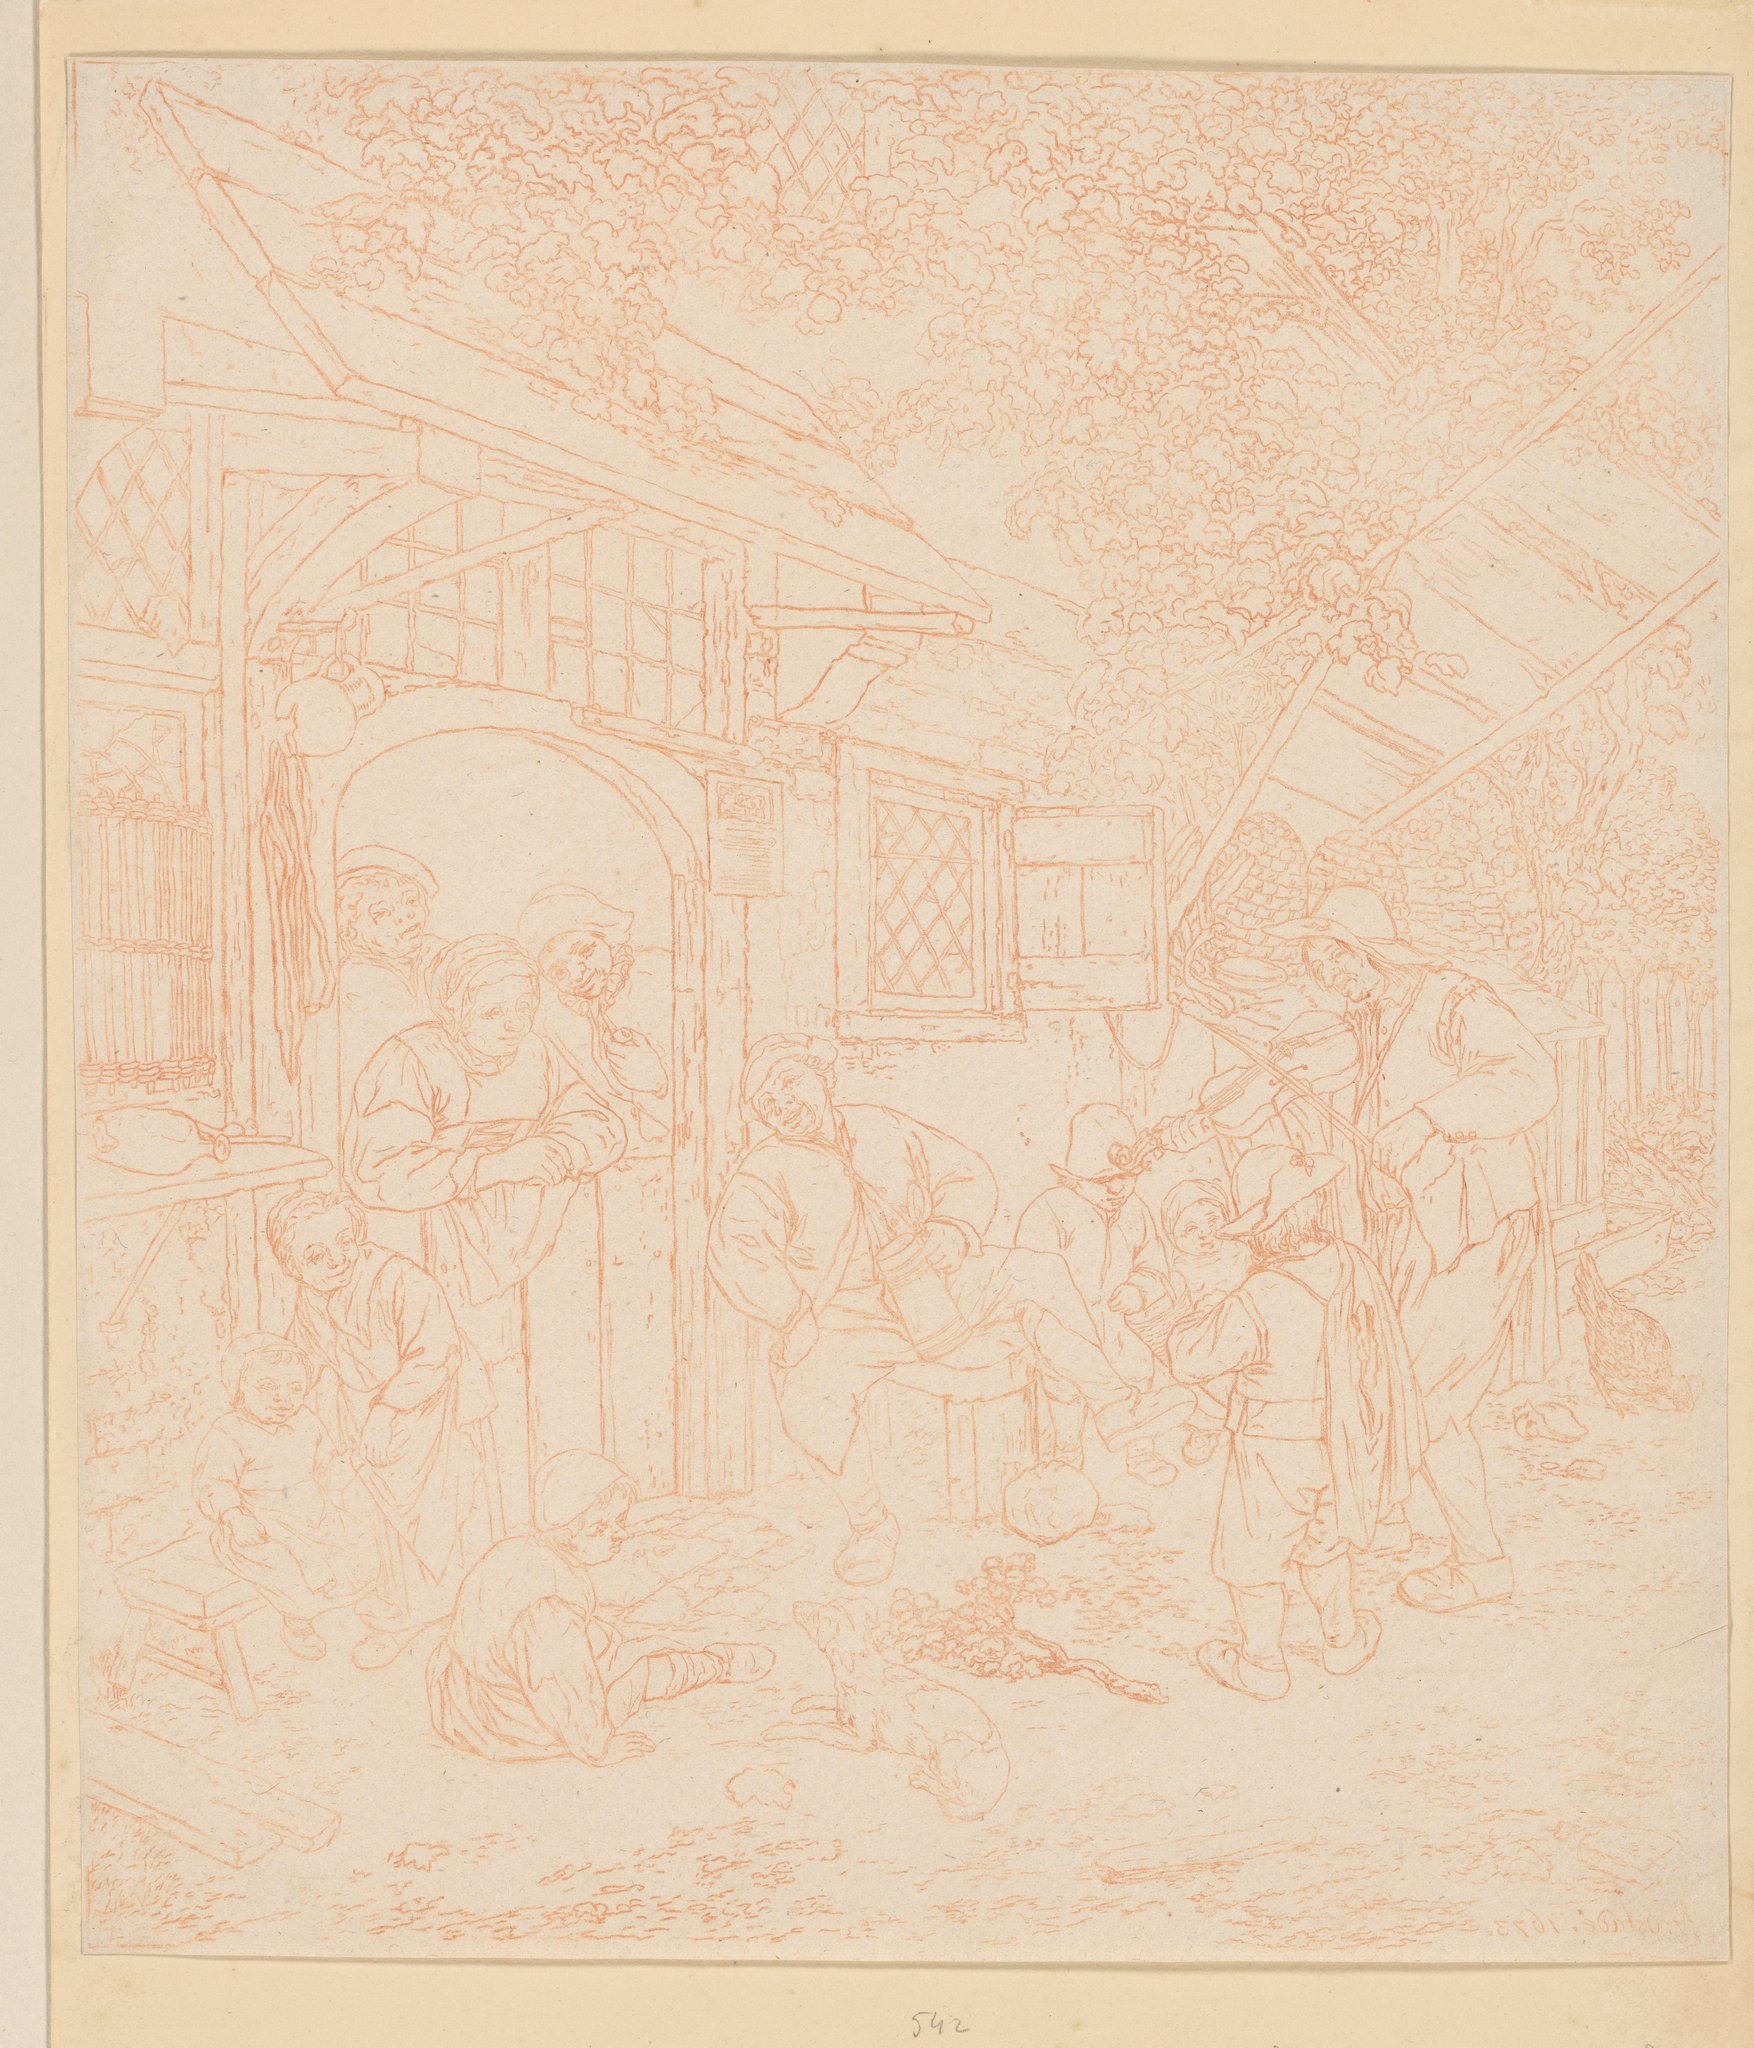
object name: drawing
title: Vioolspeler voor een herberg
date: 1766-1770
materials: chalk, paper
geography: amsterdam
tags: one person playing string instrument (bowed), inn, coffee-house, public house, etc., dog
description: Een man met viool en een jongen met draailier maken muziek bij een herberg. Volwassenen en kinderen luisteren. Een vrouw leunt over de onderdeur. De doordruktekening ligt los in een album, zie blad 17.